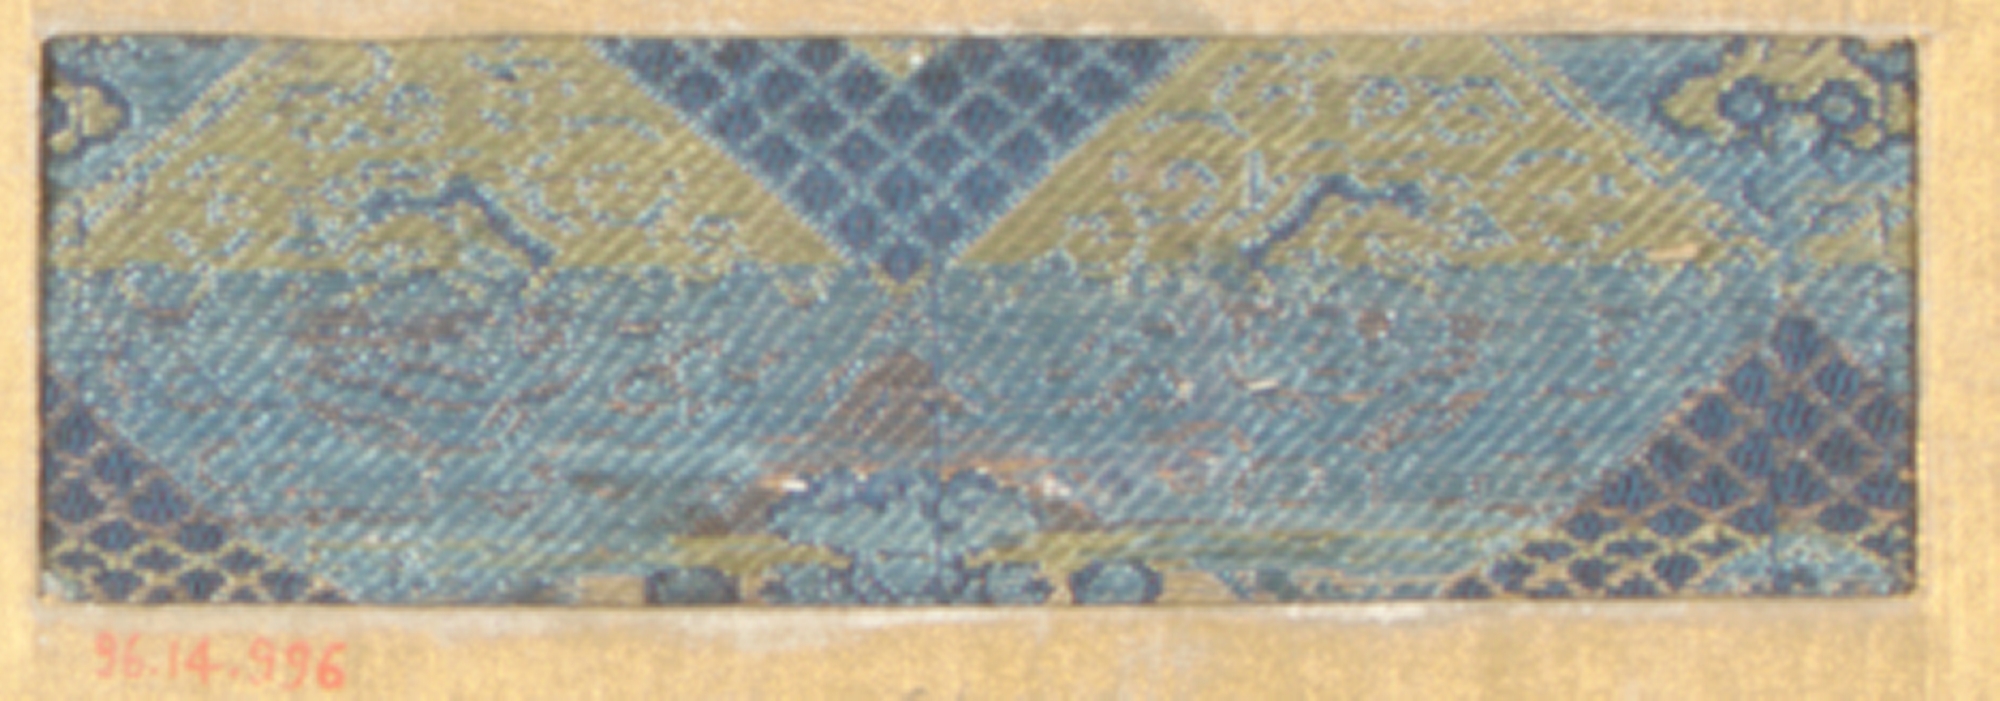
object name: piece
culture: japanese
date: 1701-1900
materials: silk